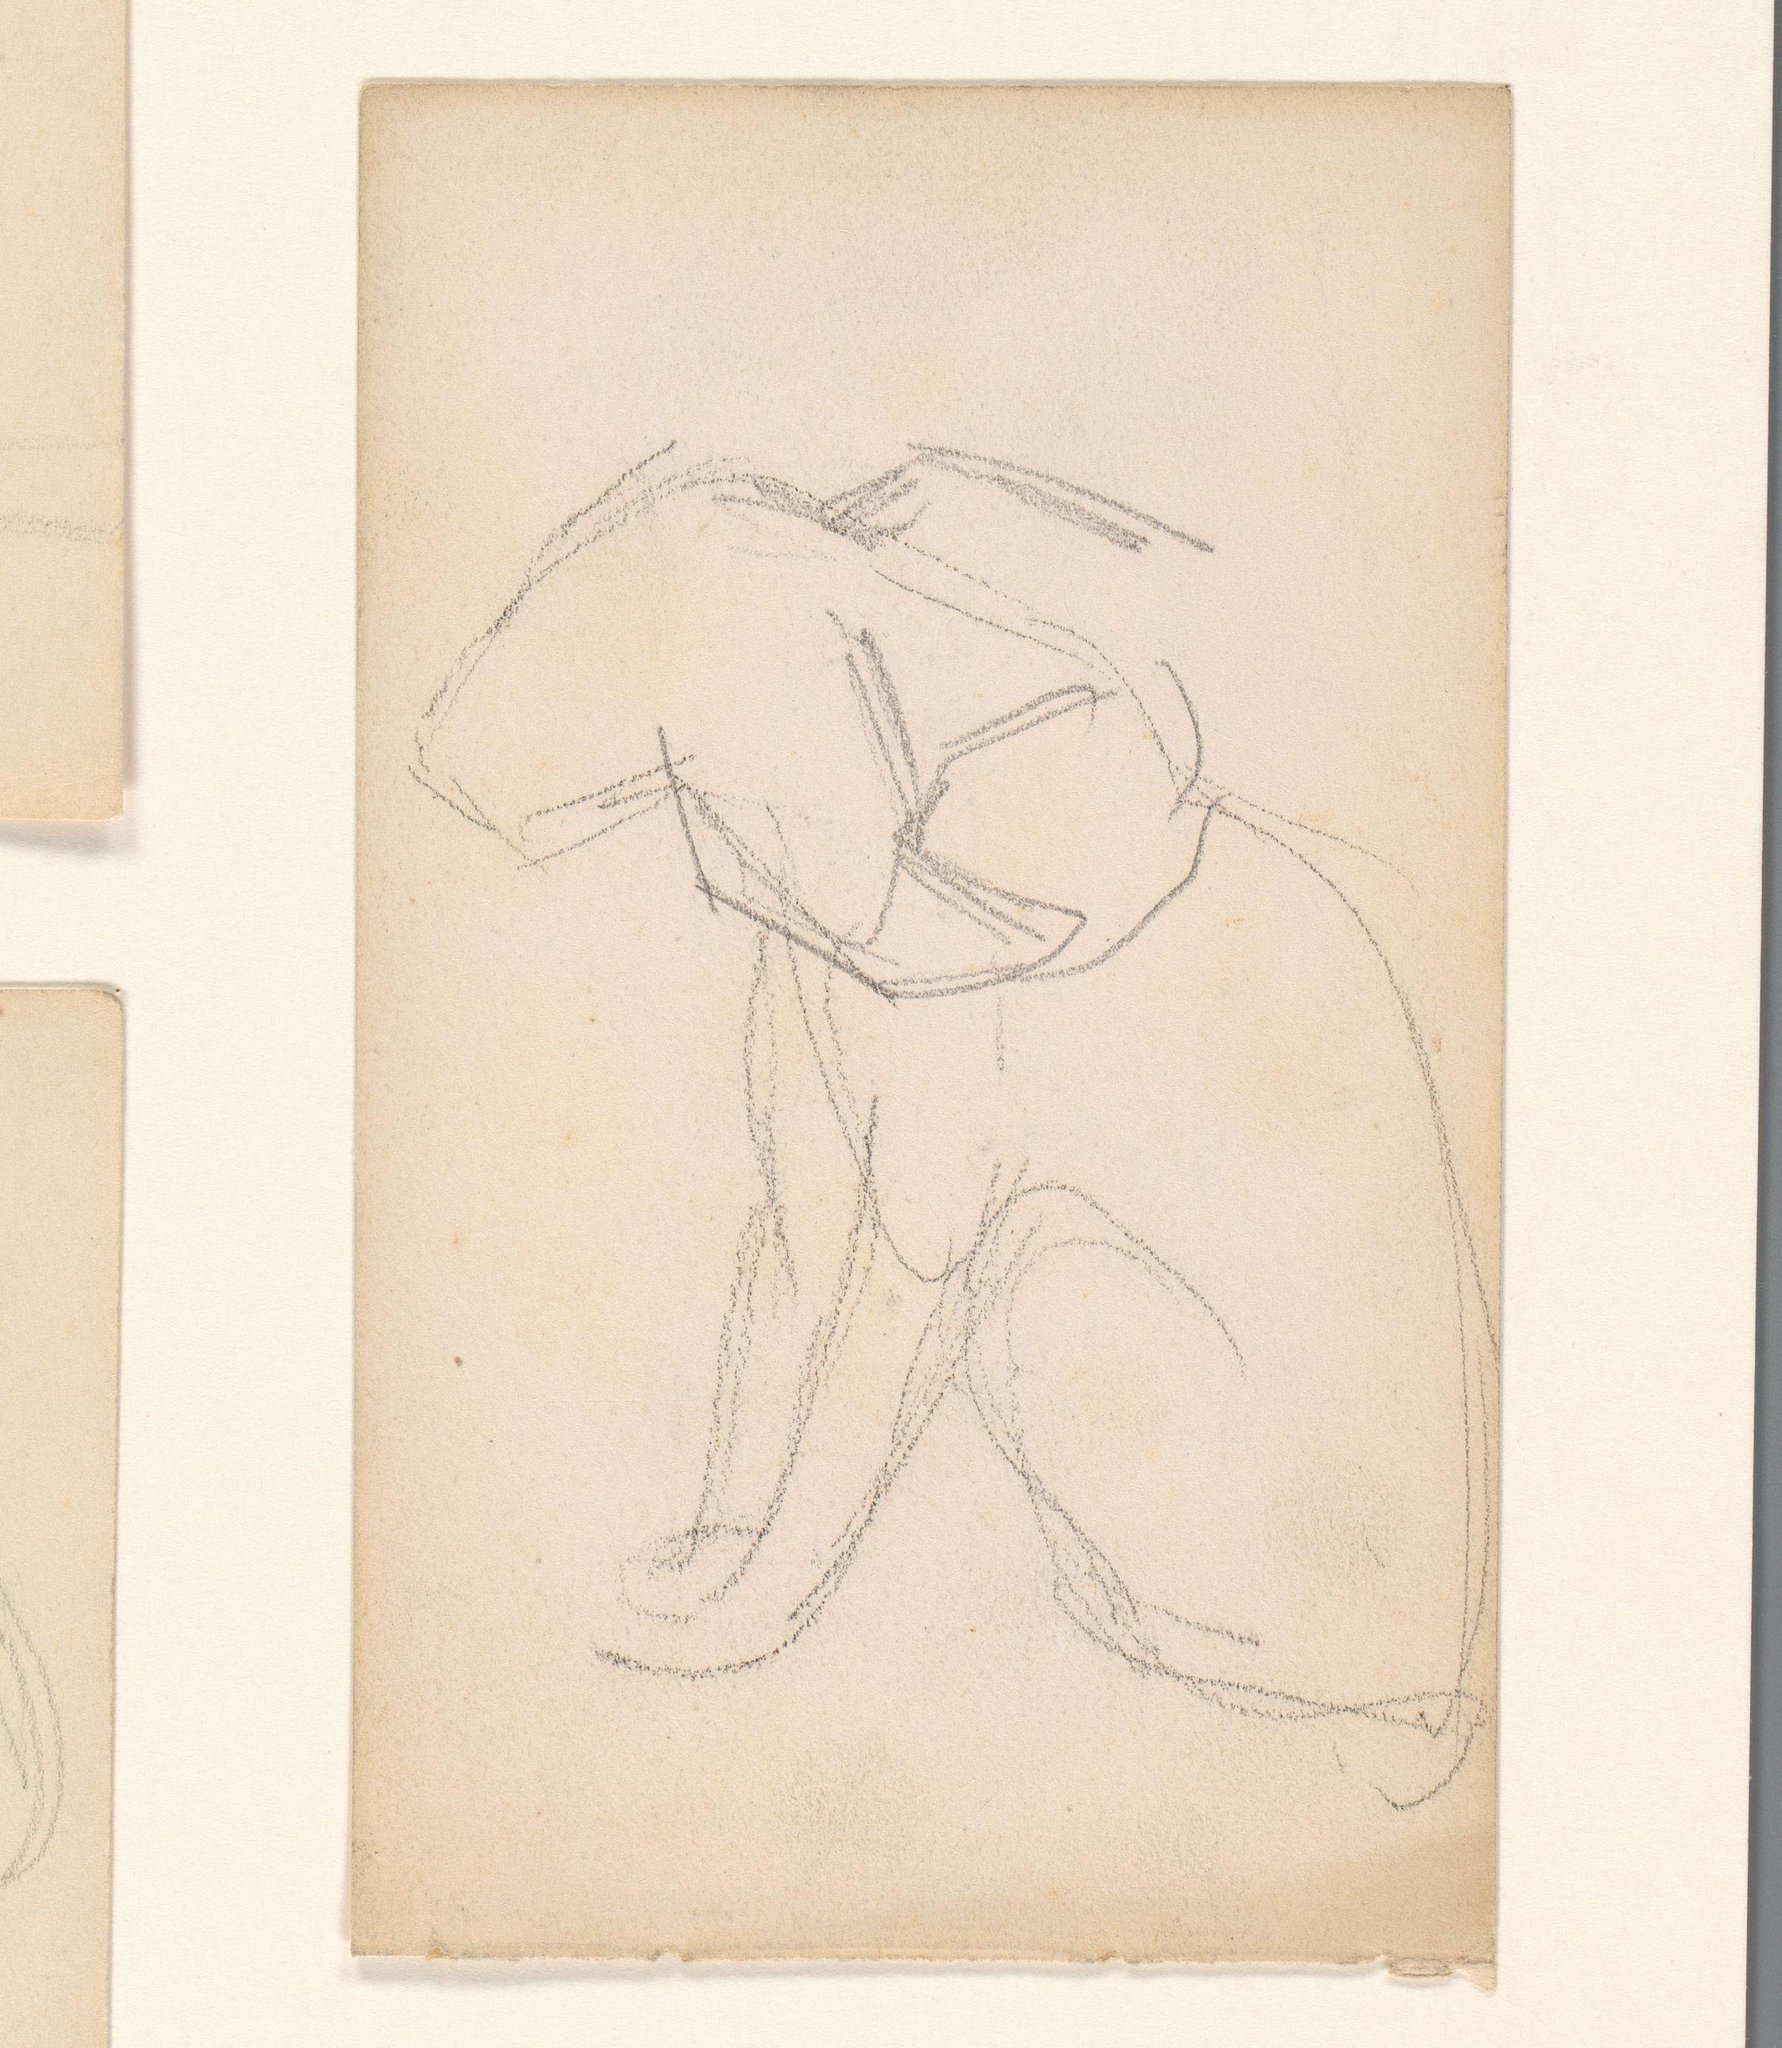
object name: drawing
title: Contouren van een zittende hond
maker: august allebé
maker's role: draughtsman, print maker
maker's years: 1838-1927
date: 1848-1927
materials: paper, pencil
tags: dog